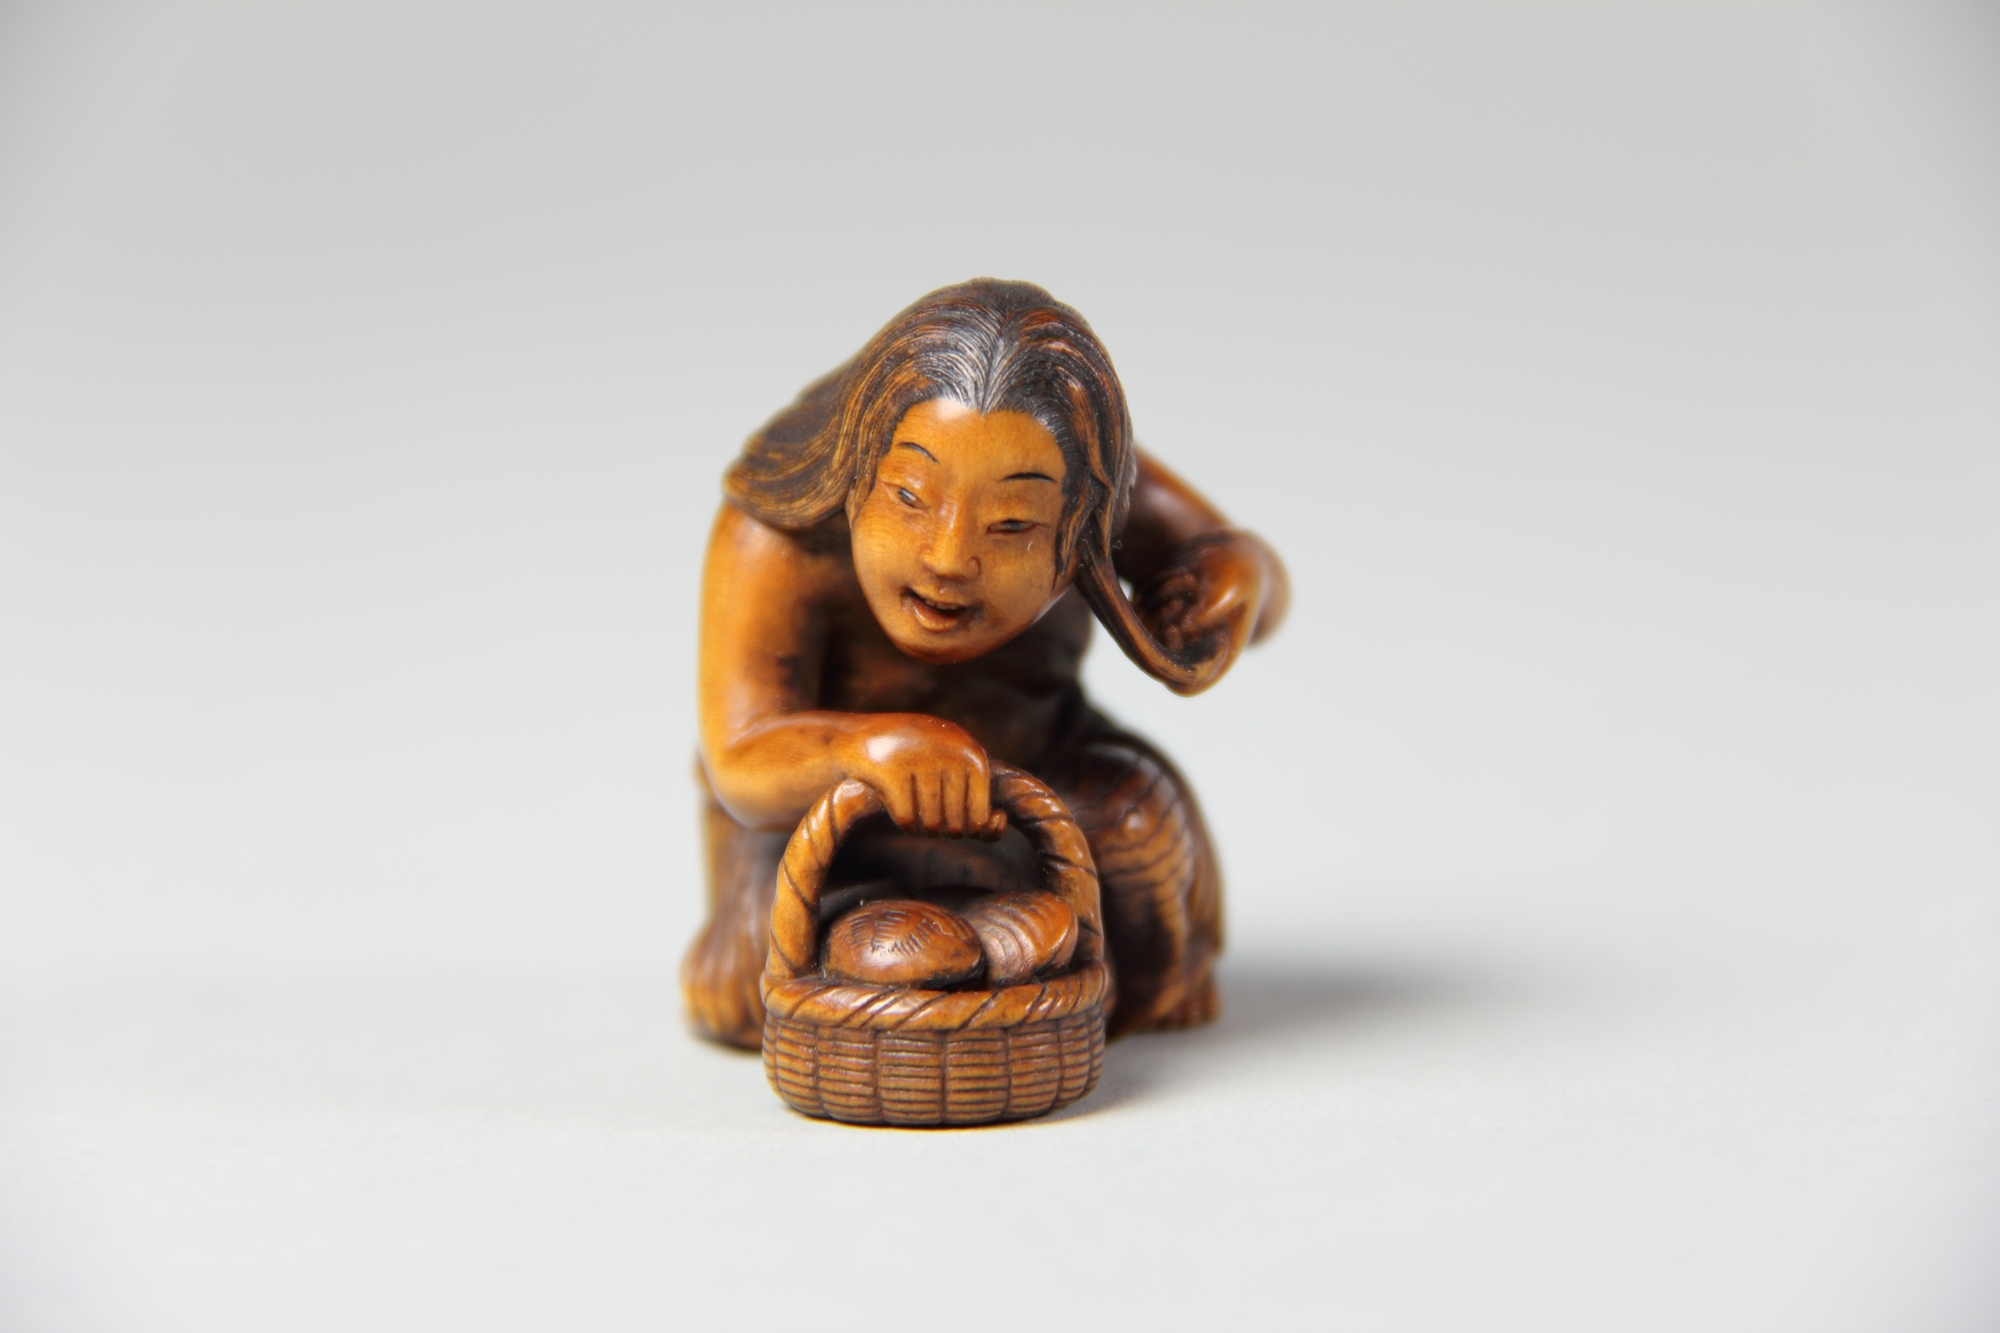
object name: netsuke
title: Netsuke of Woman with a Basket of Clams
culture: japanese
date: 1801-1900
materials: wood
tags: women